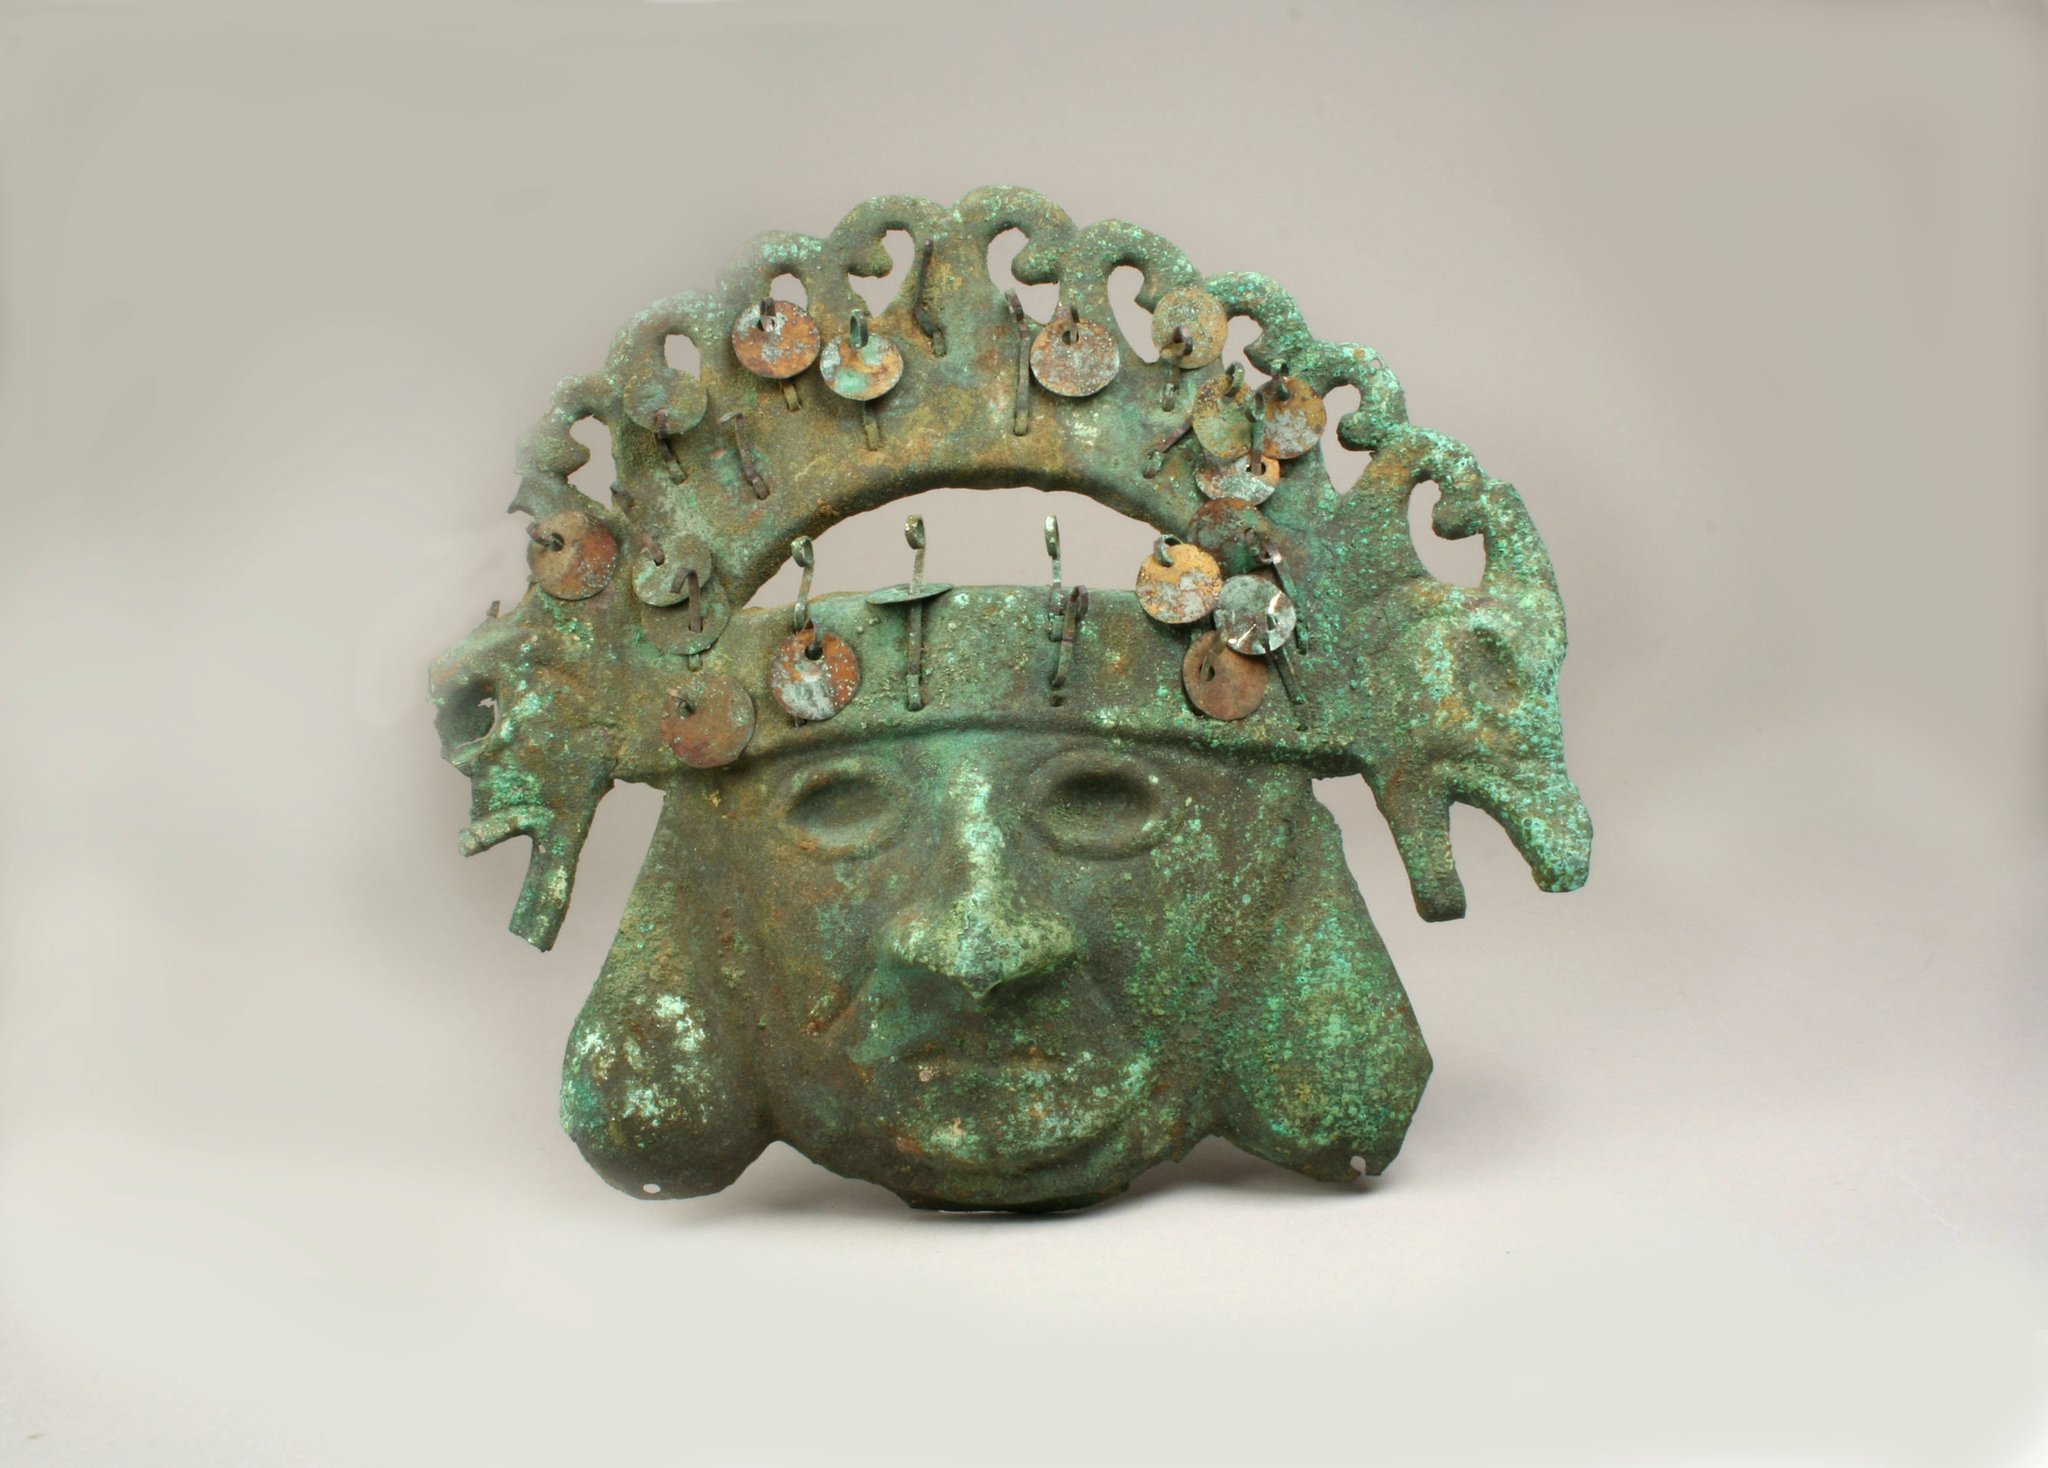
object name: ornament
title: Mask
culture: moche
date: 501-700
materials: gilt copper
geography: peru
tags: masks